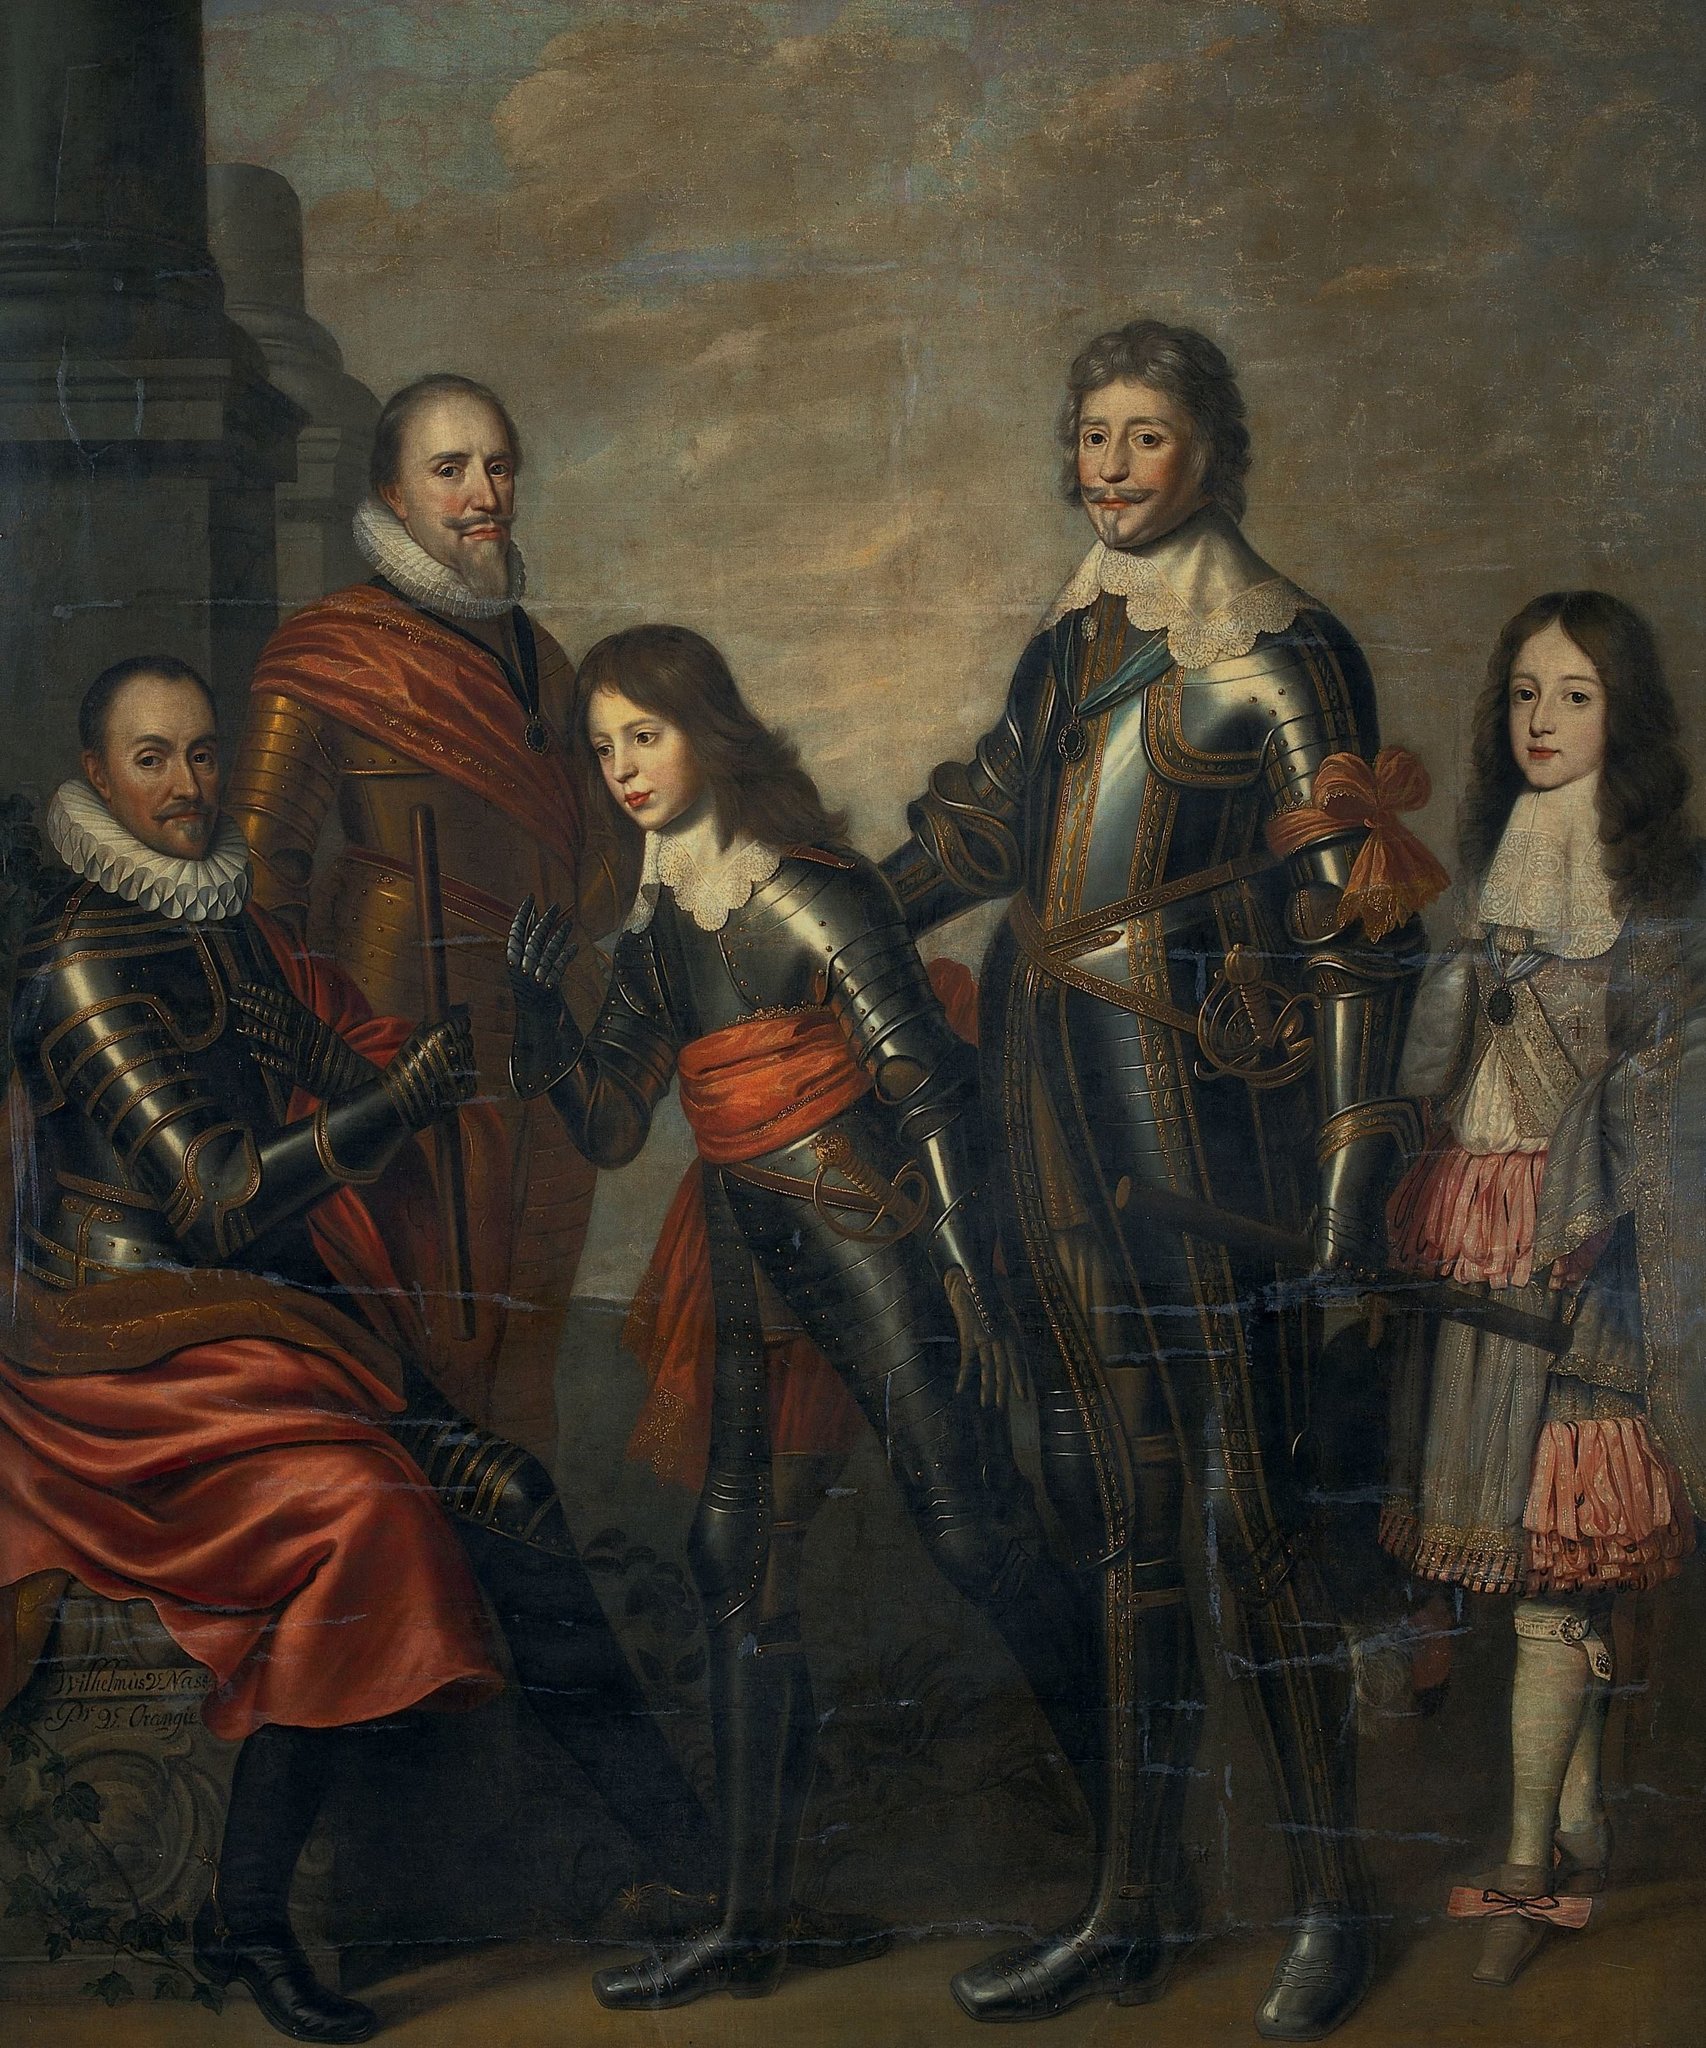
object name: painting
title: Four Generations of the Princes of Orange: William I, Maurice and Frederick Henry, William II and William III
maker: pieter nason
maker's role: painter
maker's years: 1612-1690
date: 1660-1662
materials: canvas, oil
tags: the hague, william iii (prince of orange and king of england, scotland, and ireland), frederick henry (prince of orange), william ii (prince of orange), delft, william i (prince of orange), maurice (prince of orange), historical persons, ruler, sovereign, netherlands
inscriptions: inscription, lower left on the base of the column: ‘Wilhelmus V Nas.e Pr. V. Orangie’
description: Vier generaties van de prinsen van Oranje. Van links naar rechts: Willem I (zittend), Maurits, Willem II, Frederik Hendrik en Willem III. Links een zuil en een afgebroken zuil. Allen in wapenrusting, behalve Willem III.